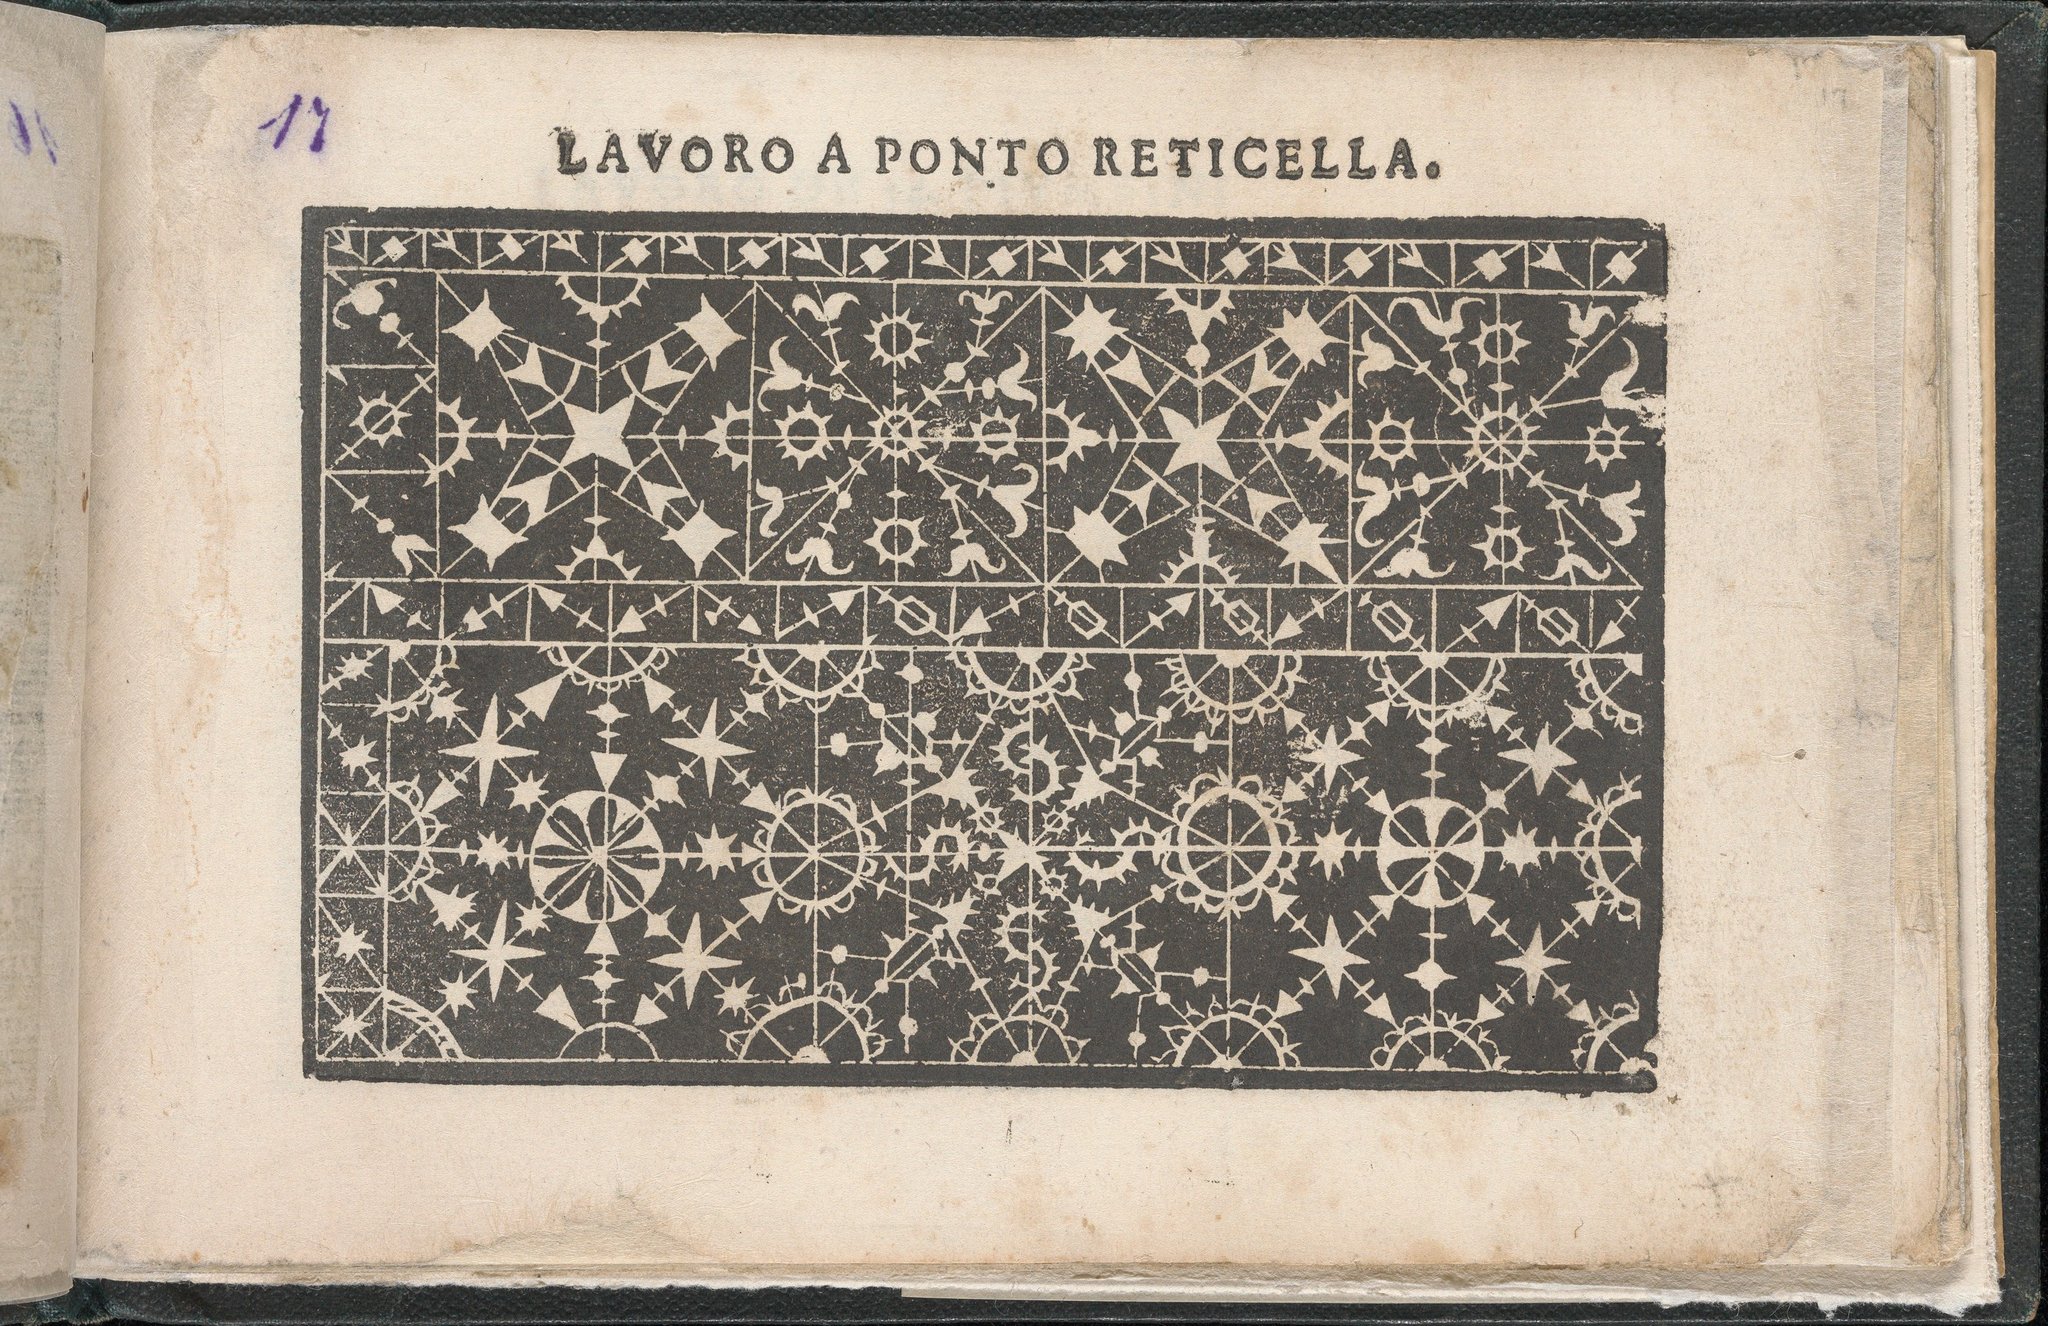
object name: book print ornament architecture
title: Gemma pretiosa della virtuose donne, page 17 (recto)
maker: isabella catanea parasole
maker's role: designer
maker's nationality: italian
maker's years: 1565-1625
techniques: woodcut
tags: ornament